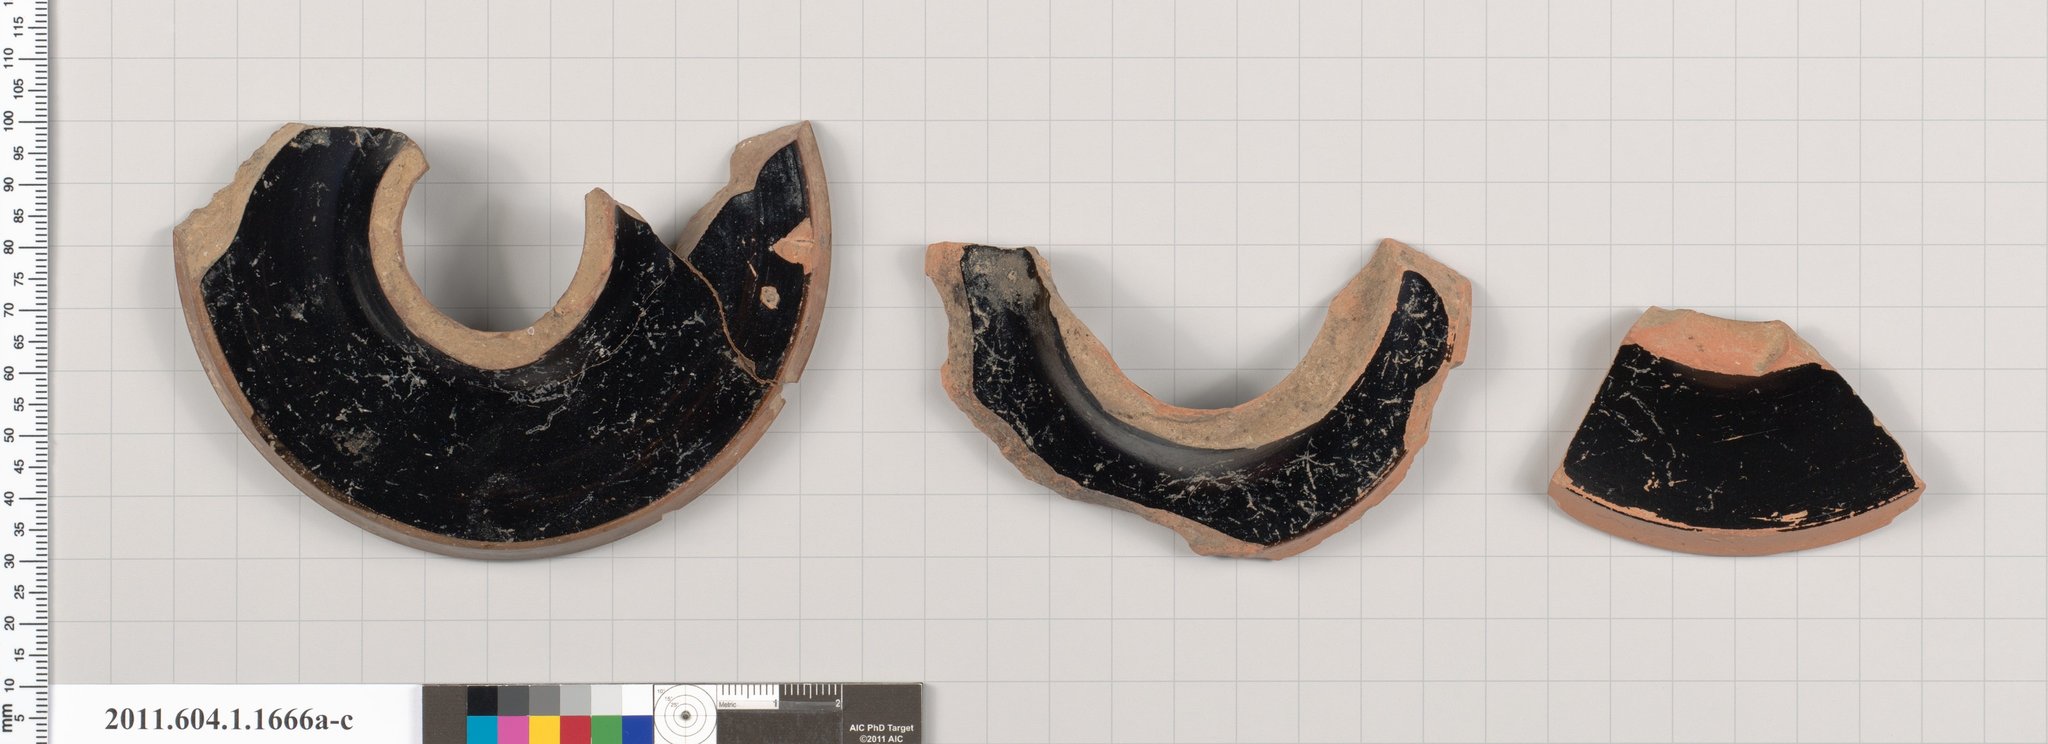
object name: kylix fragment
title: Terracotta fragment of a kylix (drinking cup)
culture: greek, attic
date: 534-468 BCE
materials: terracotta